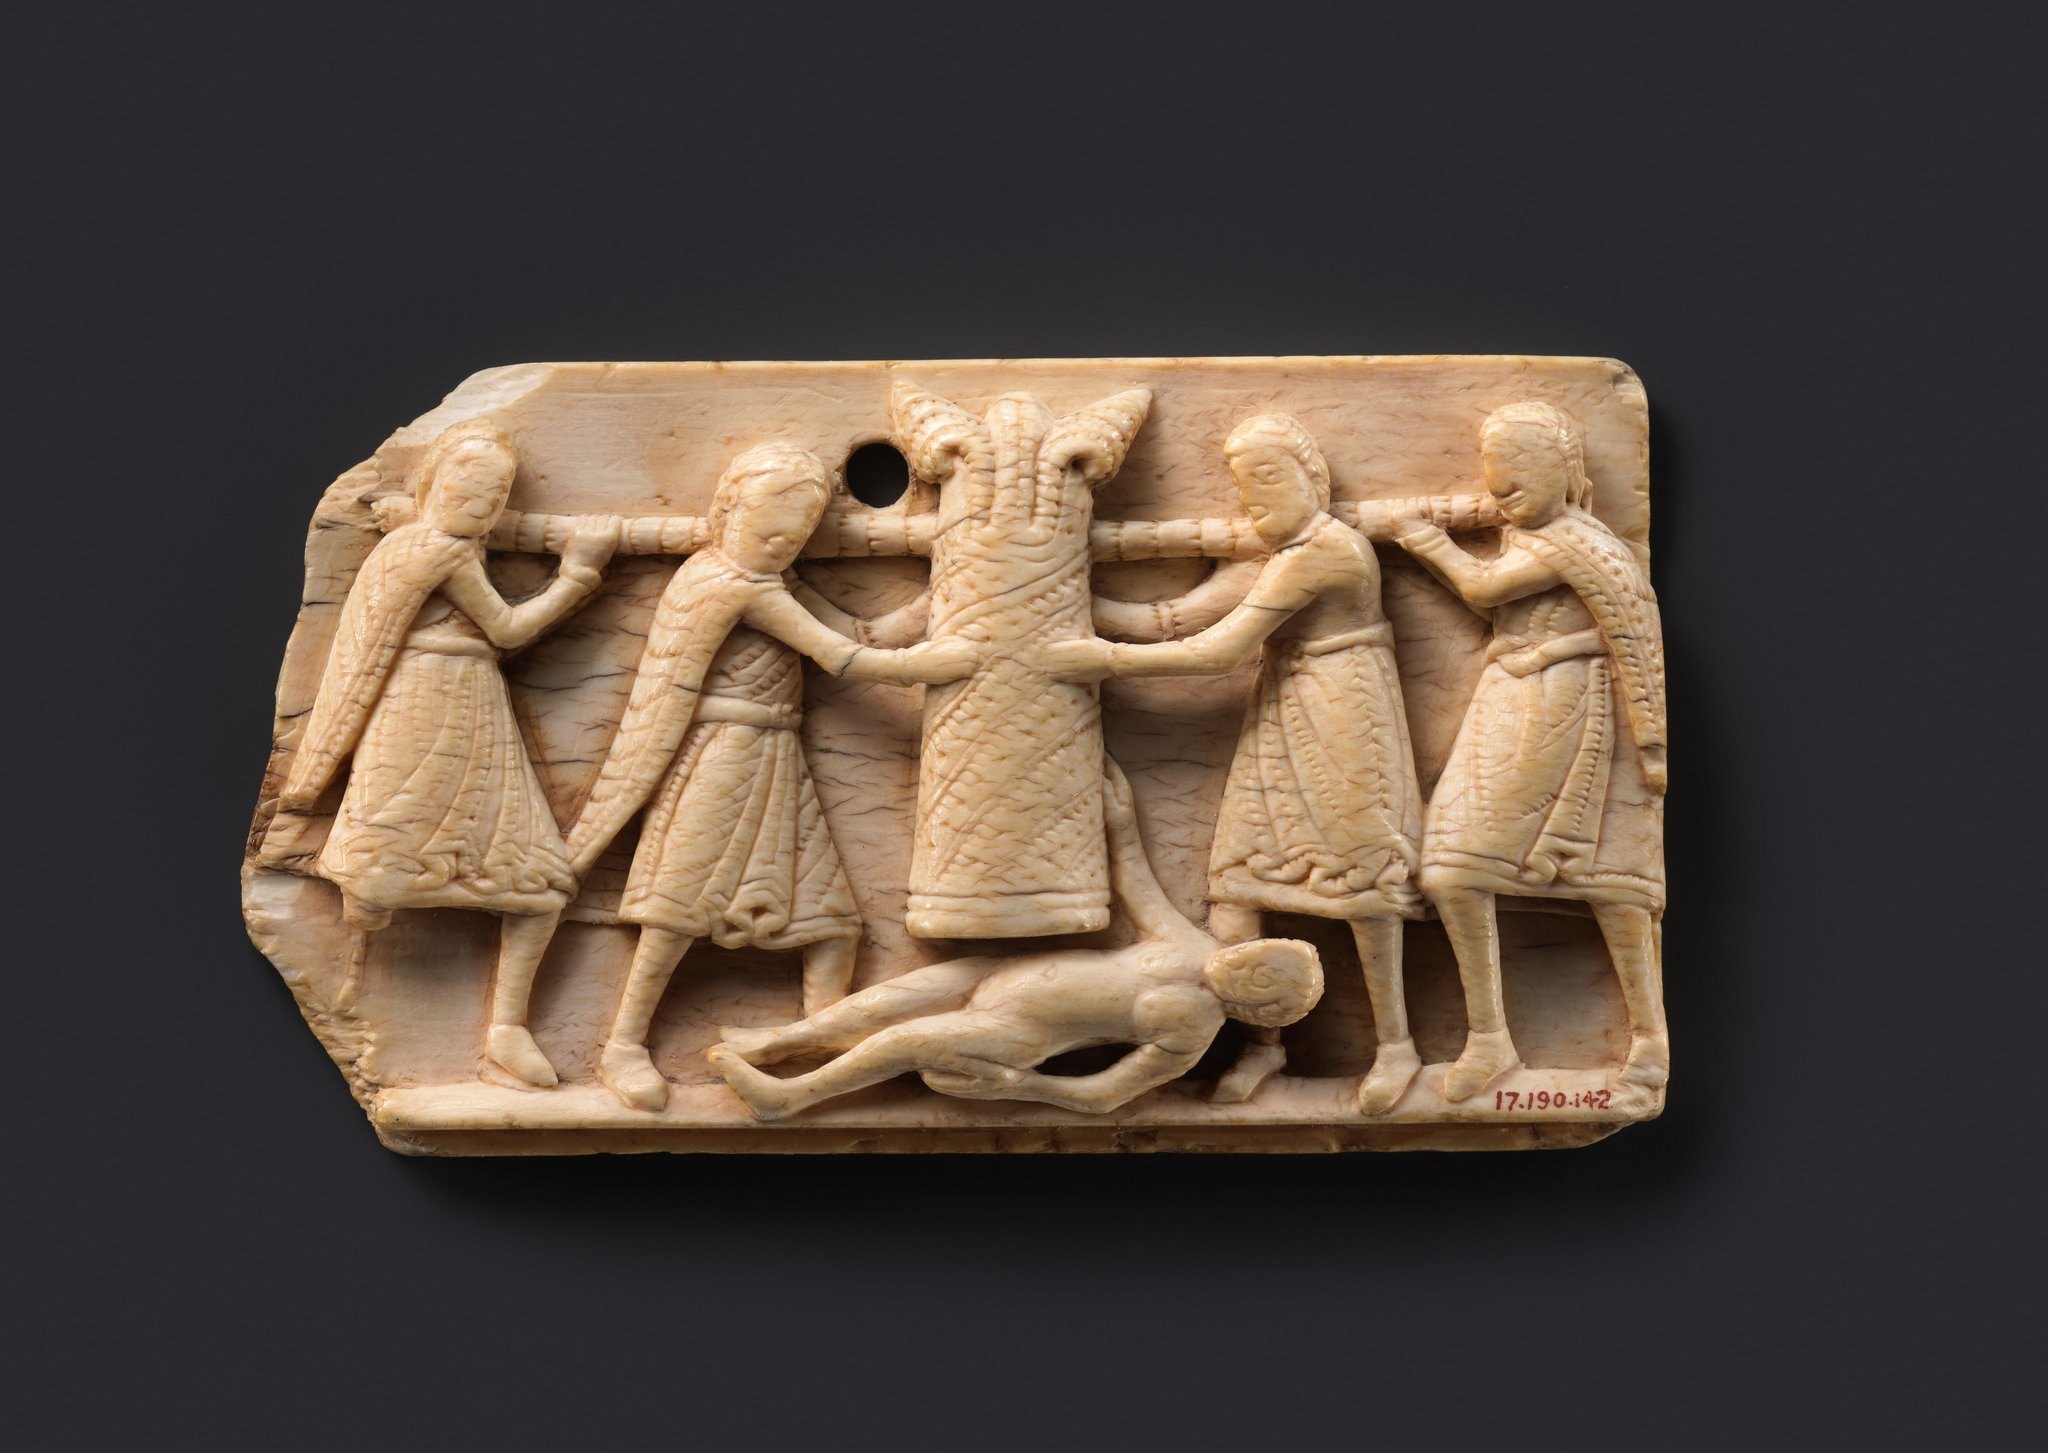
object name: panel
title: Panel with Scene from the Life of a Saint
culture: spanish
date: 1051-1100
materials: ivory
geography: spain